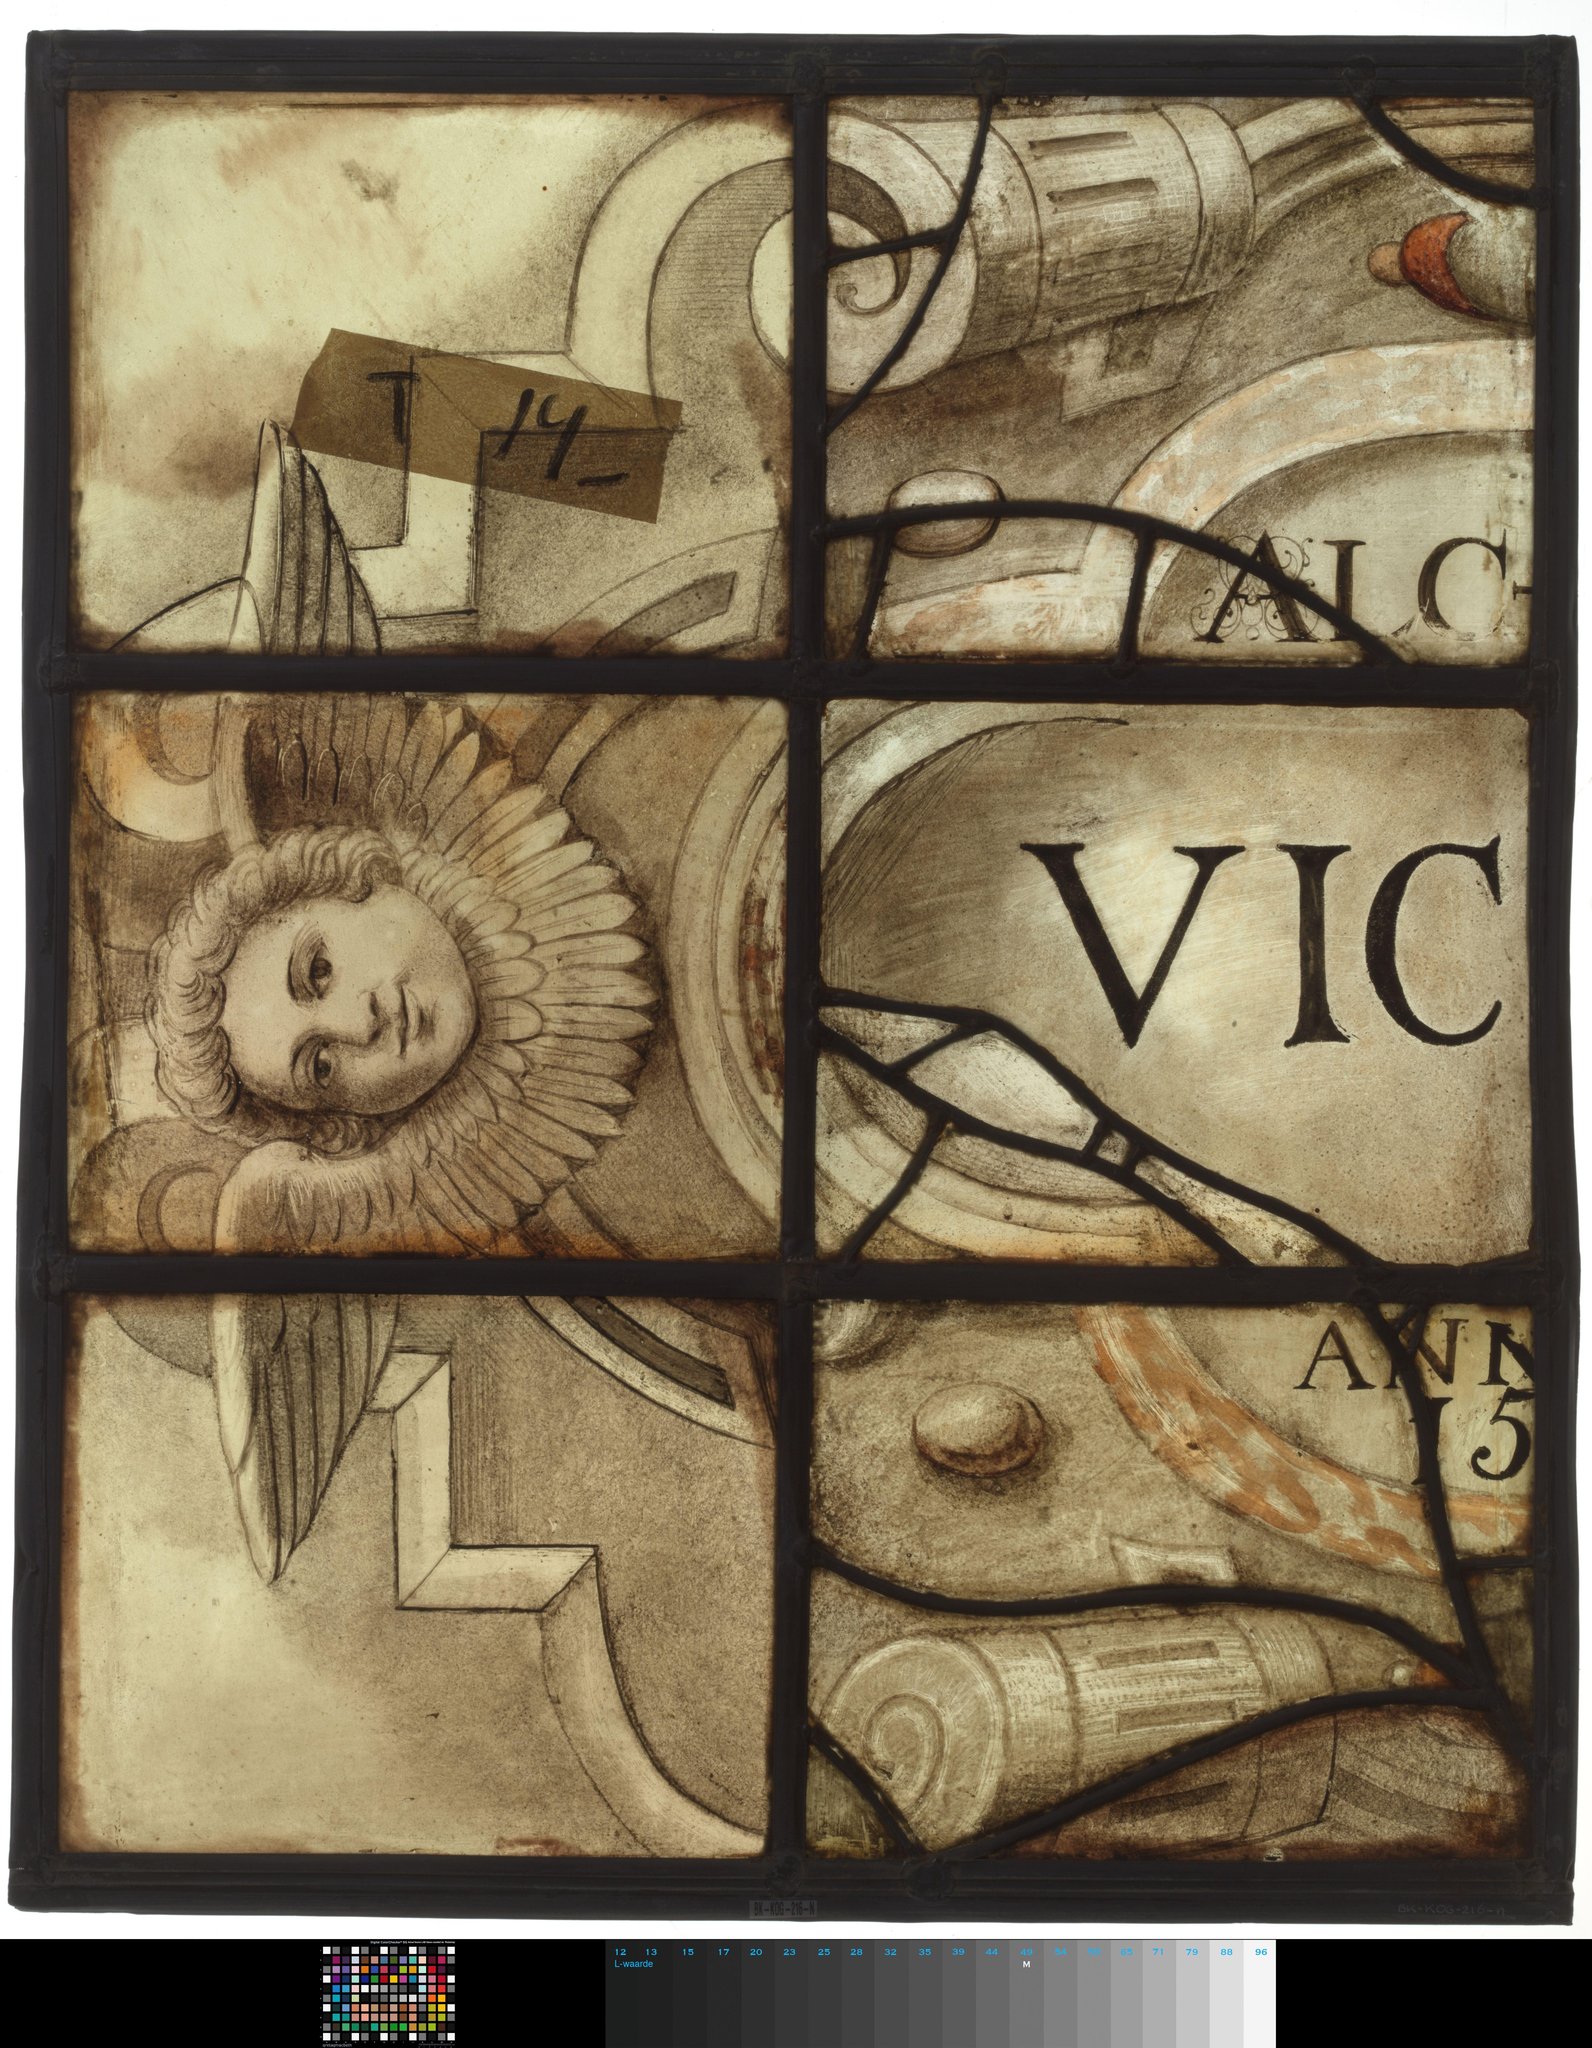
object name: light window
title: Ruit met het wapen van Alkmaar met onderschrift "Alkmaria Victrix 1573"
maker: Anonymous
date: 1573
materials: glass, lead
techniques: leading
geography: netherlands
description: Ruit, glas-in-lood, bestaande uit zestien afzonderlijke panelen die tezamen het wapen van Alkmaar laten zien. Onderschrift: ALKMARIA VICTRIX. Gedateerd 1573.